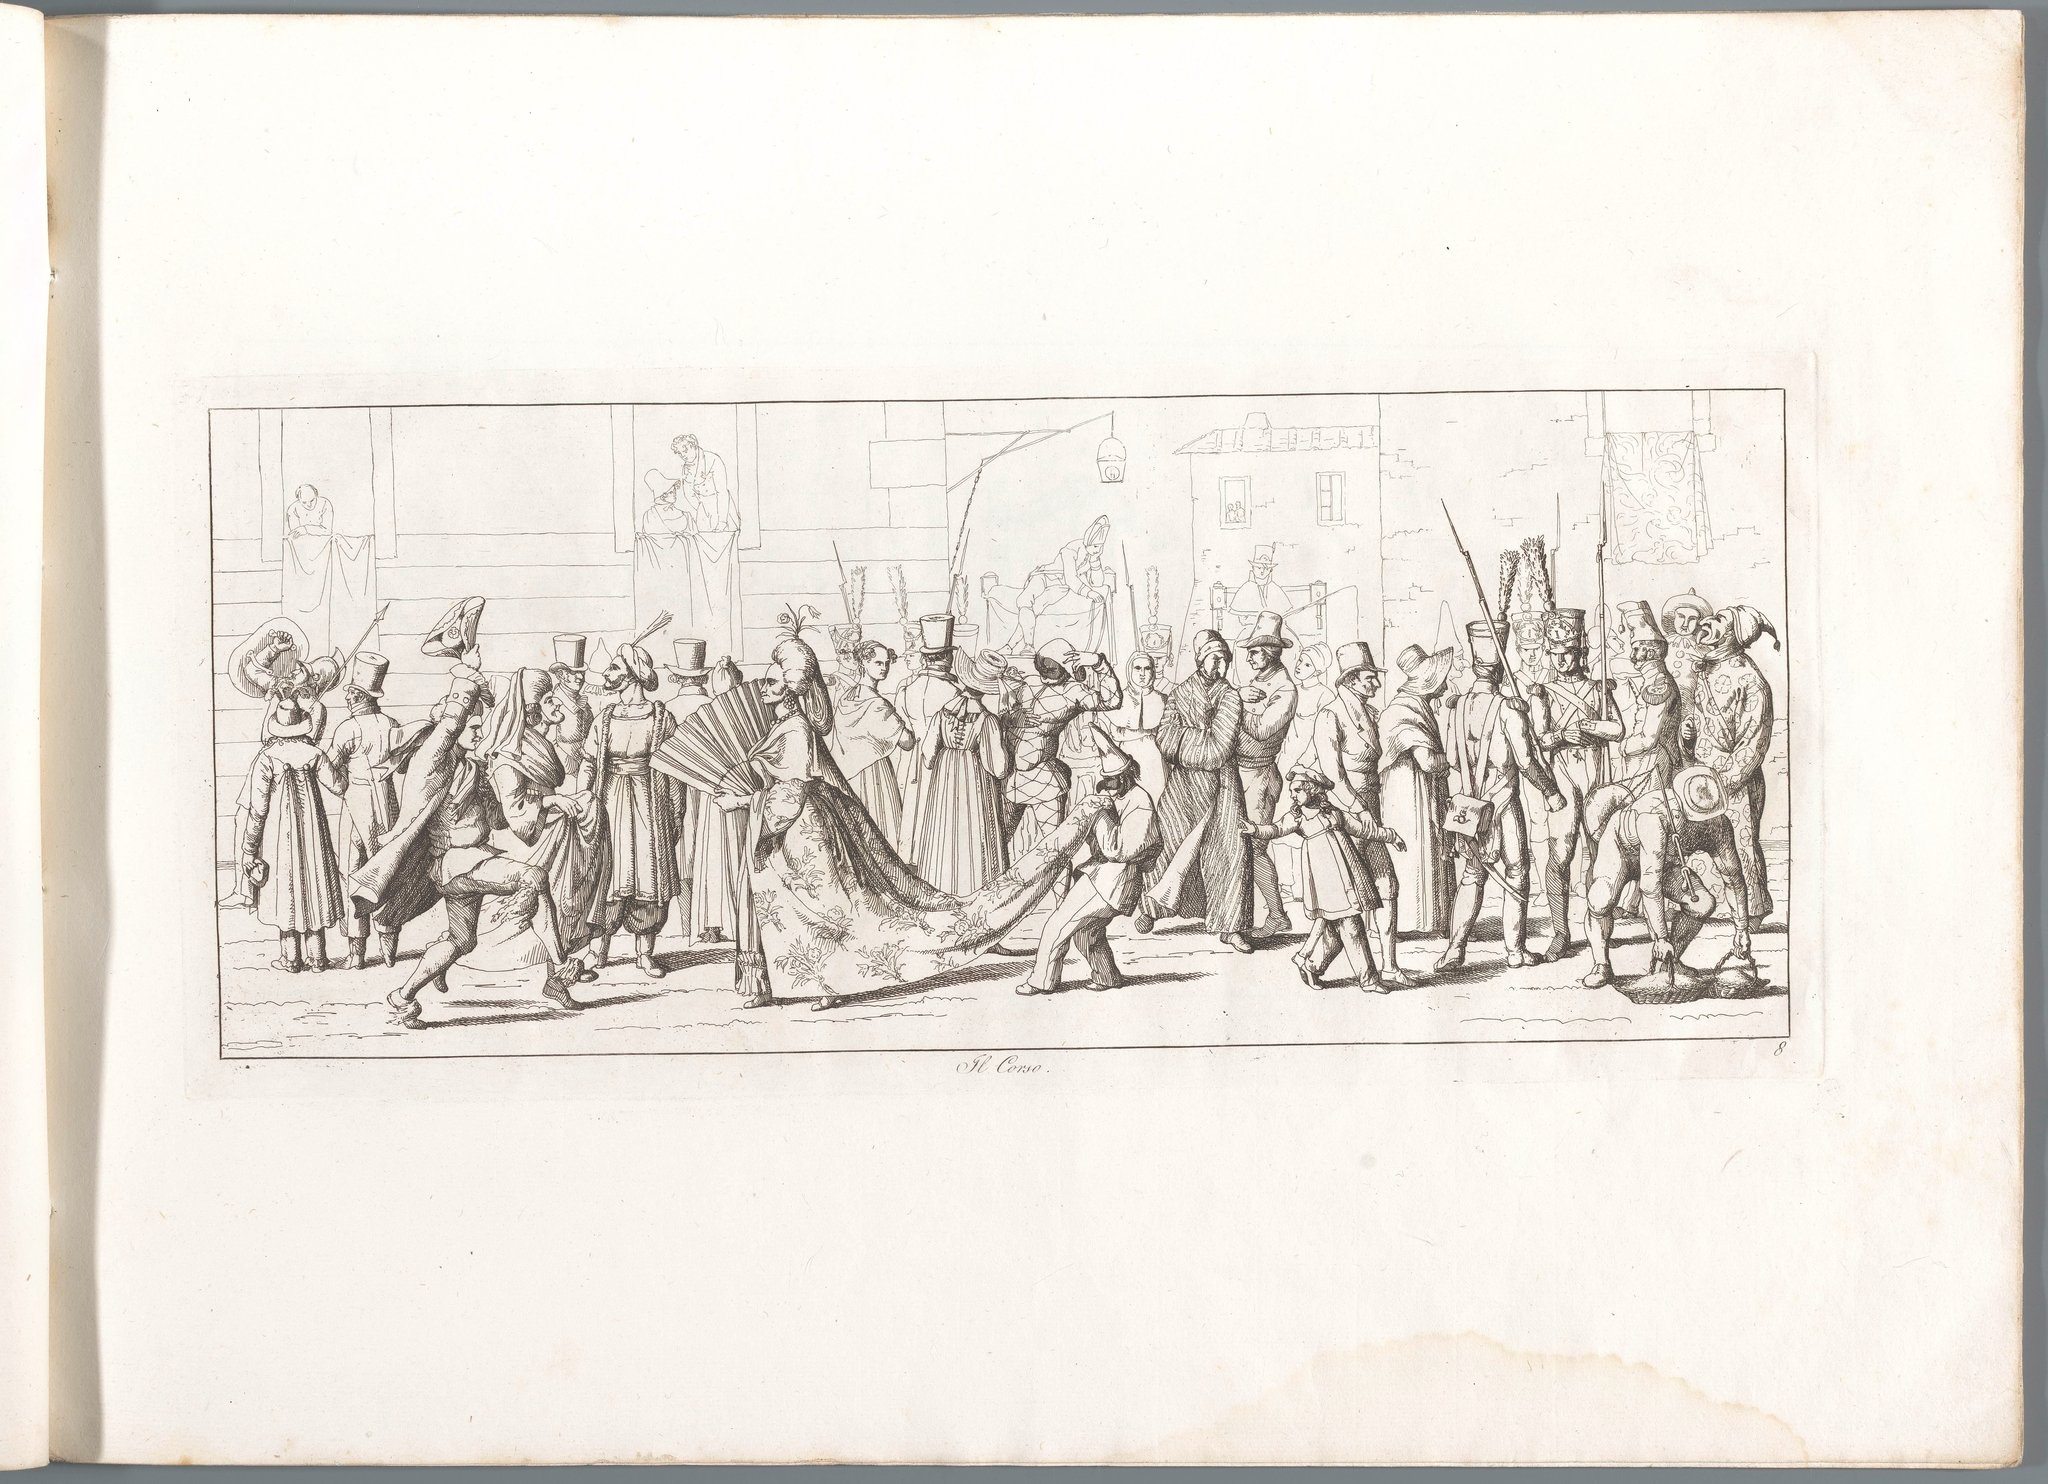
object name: print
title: Via del Corso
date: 1820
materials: paper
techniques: etching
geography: rome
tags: carnival, shrovetide (non-liturgical celebration), rome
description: Carnavalsoptocht over de Via del Corso. Onderdeel van een prentwerk met een serie van twintig prenten over de viering van carnaval in Rome.